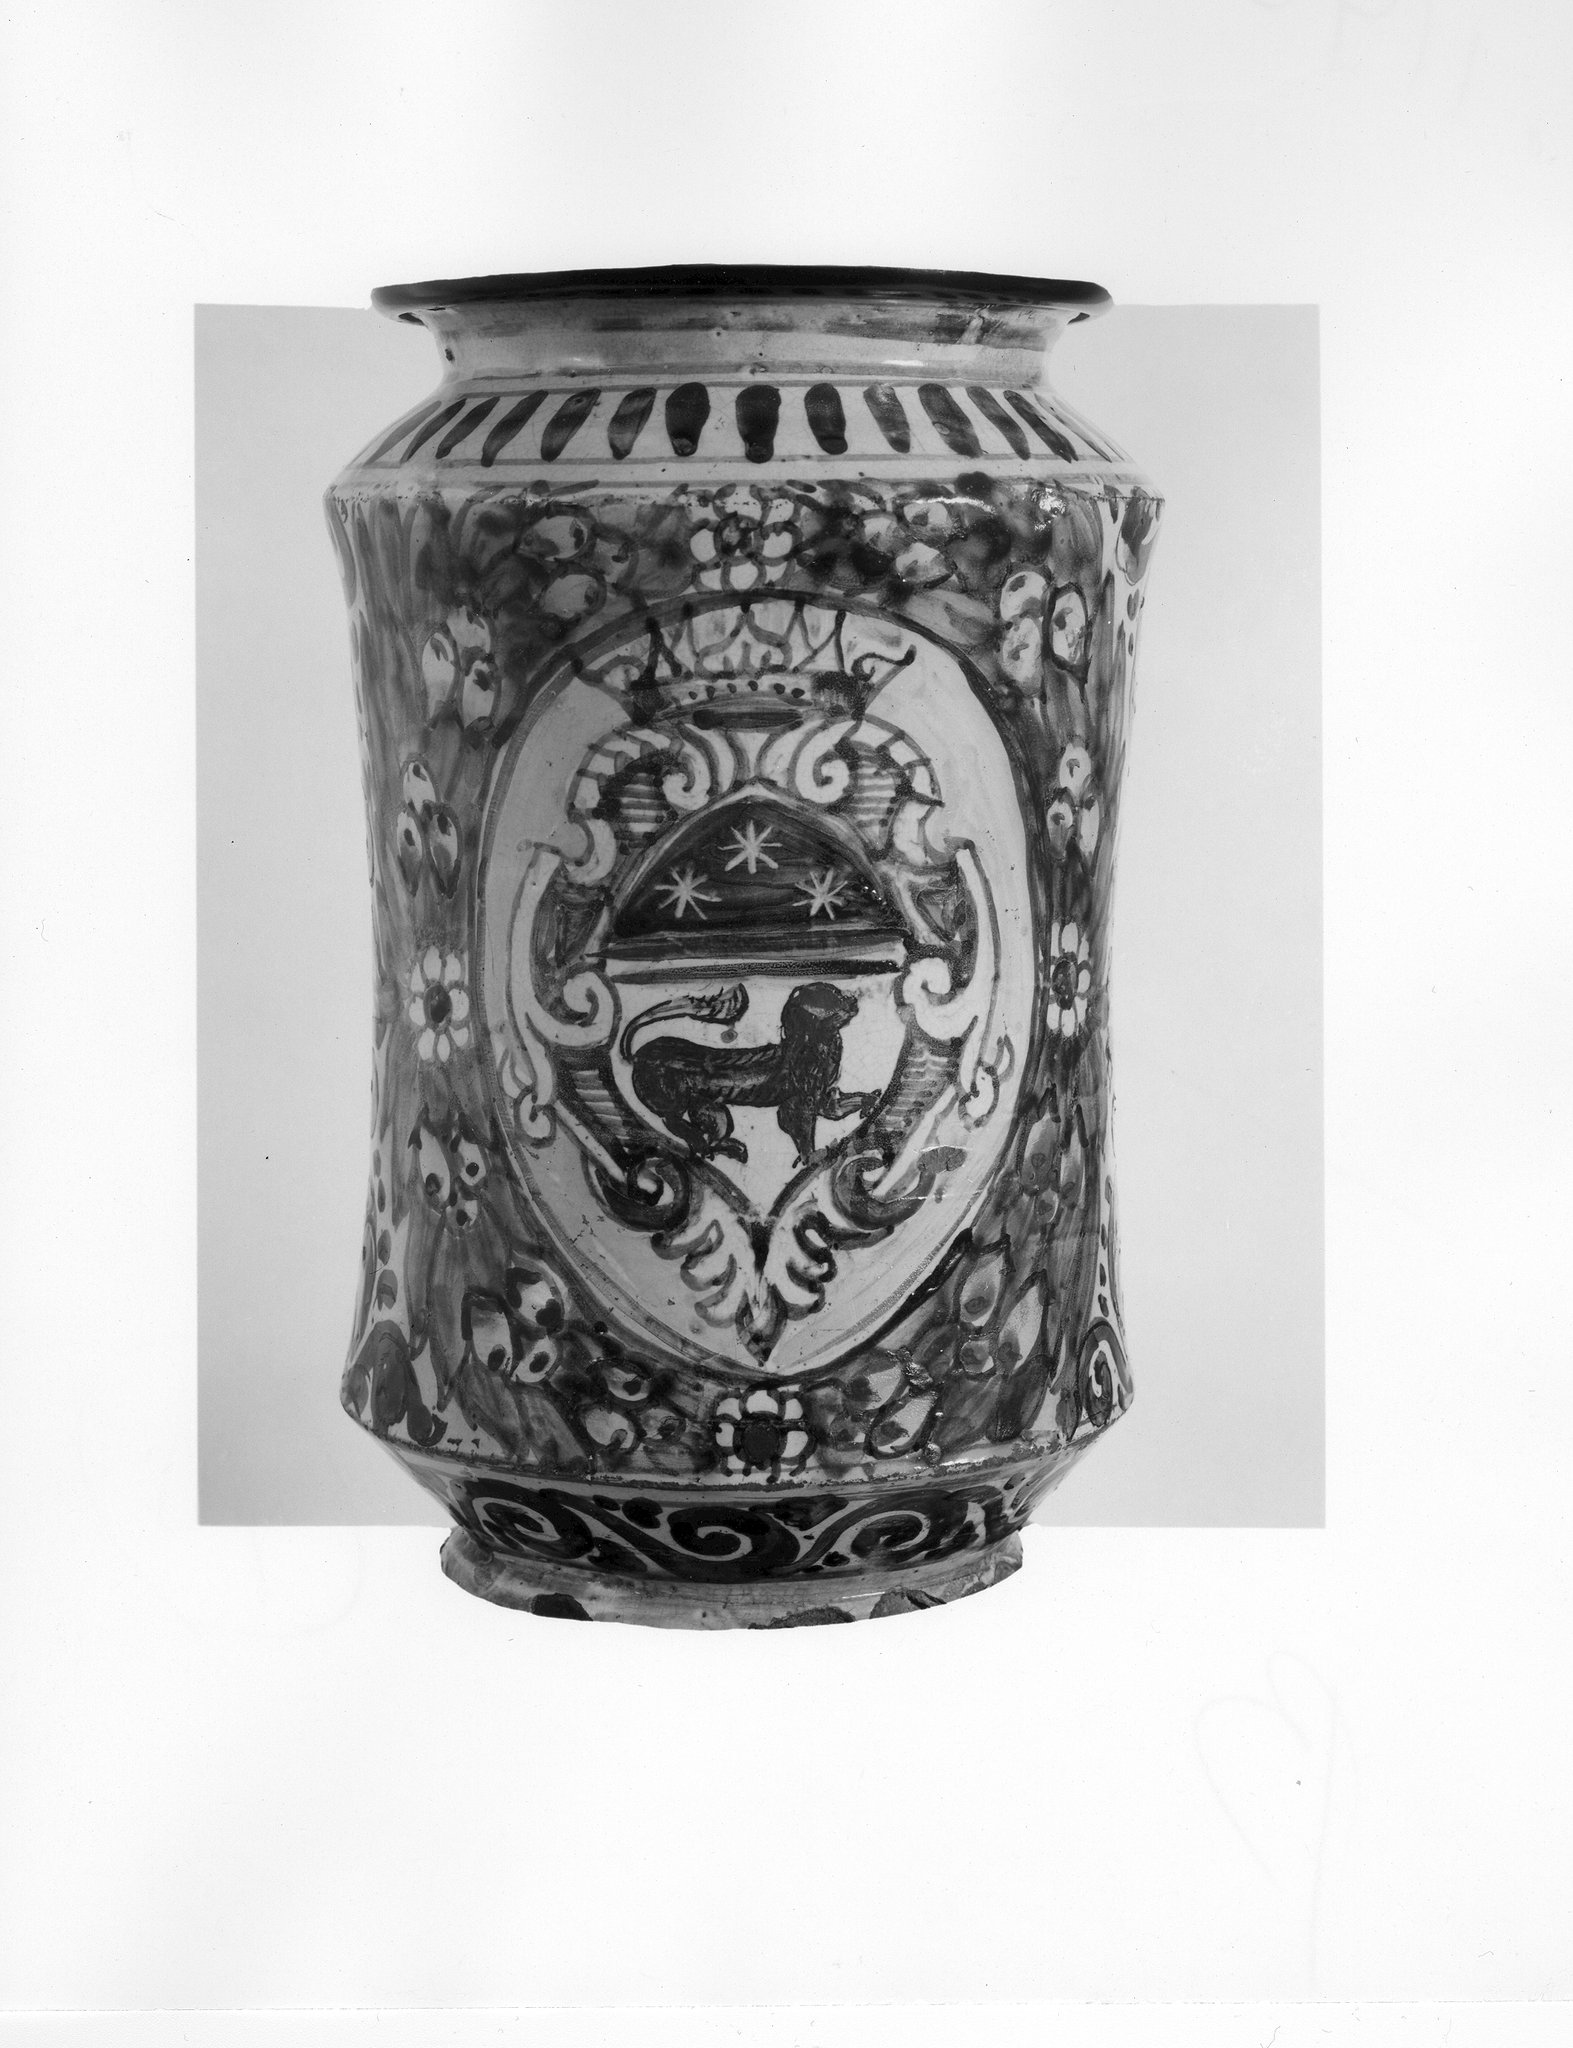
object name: albarello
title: Apothecary jar (albarello)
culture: italian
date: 1601-1700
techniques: maiolica, glazing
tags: coat of arms